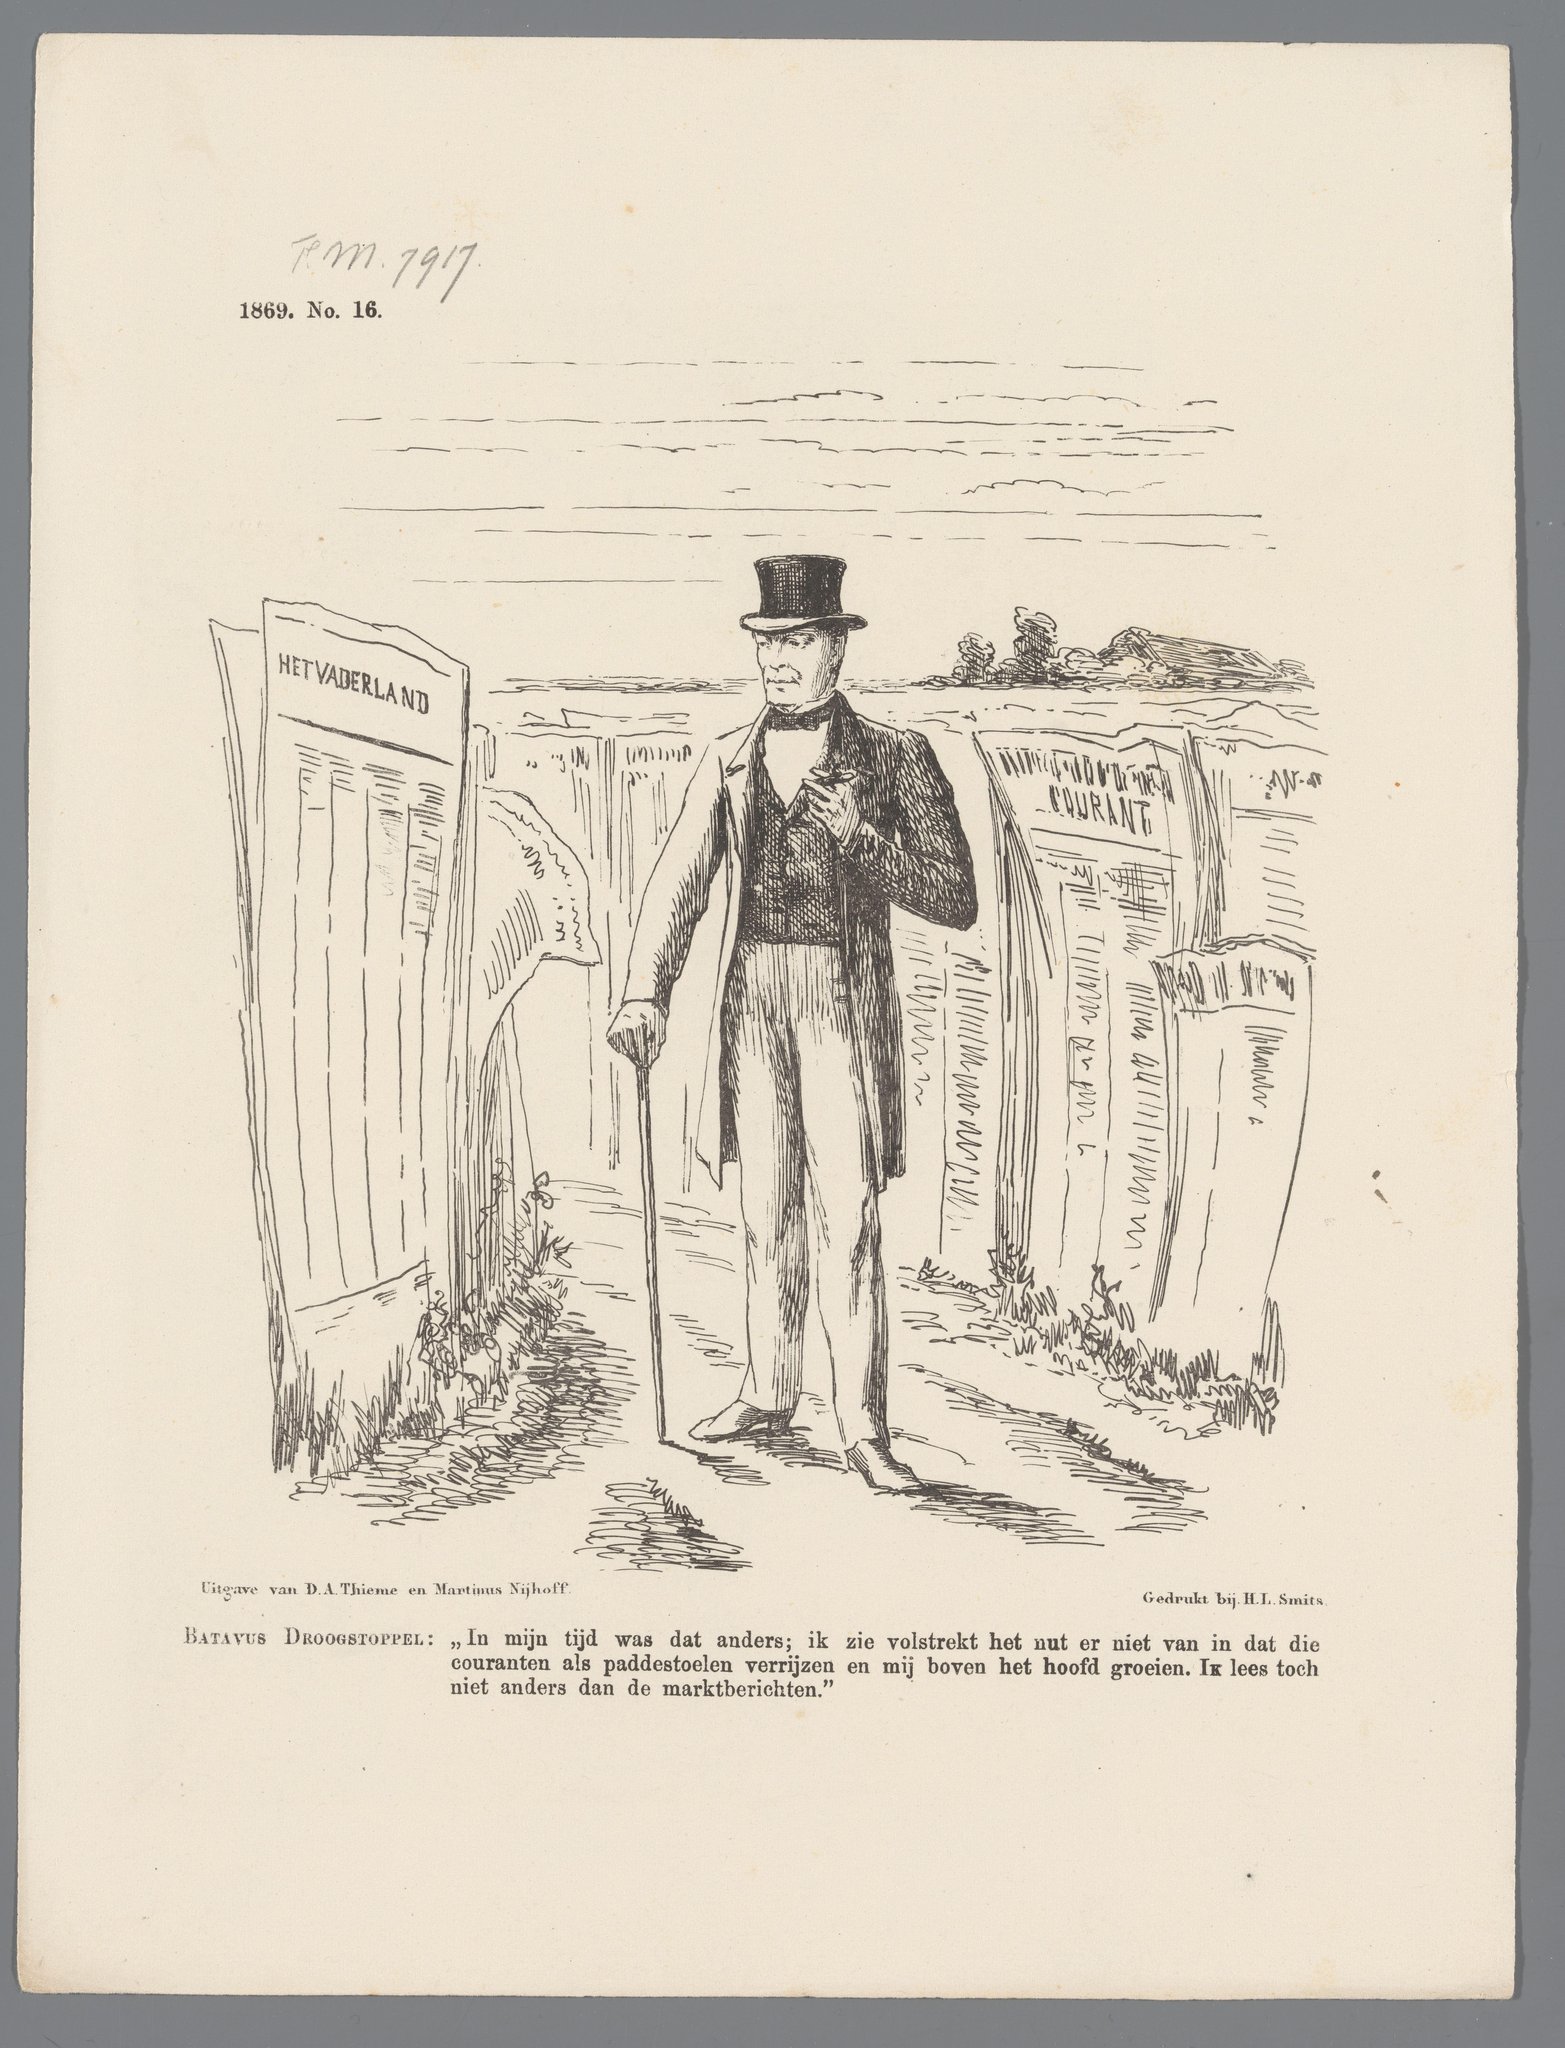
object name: print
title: Spotprent over de groei van aantal dagbladen na de afschaffing van het dagbladzegel, 1869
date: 1869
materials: paper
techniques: lithograph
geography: netherlands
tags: newspaper, news-sheet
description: Spotprent over de groei van aantal dagbladen na de afschaffing van het dagbladzegel, Batavus Droogstoppel wandelend tussen een haag van dagbladen. Plaat verschenen bij het weekblad De Nederlandsche Spectator, nr. 16, 1869.